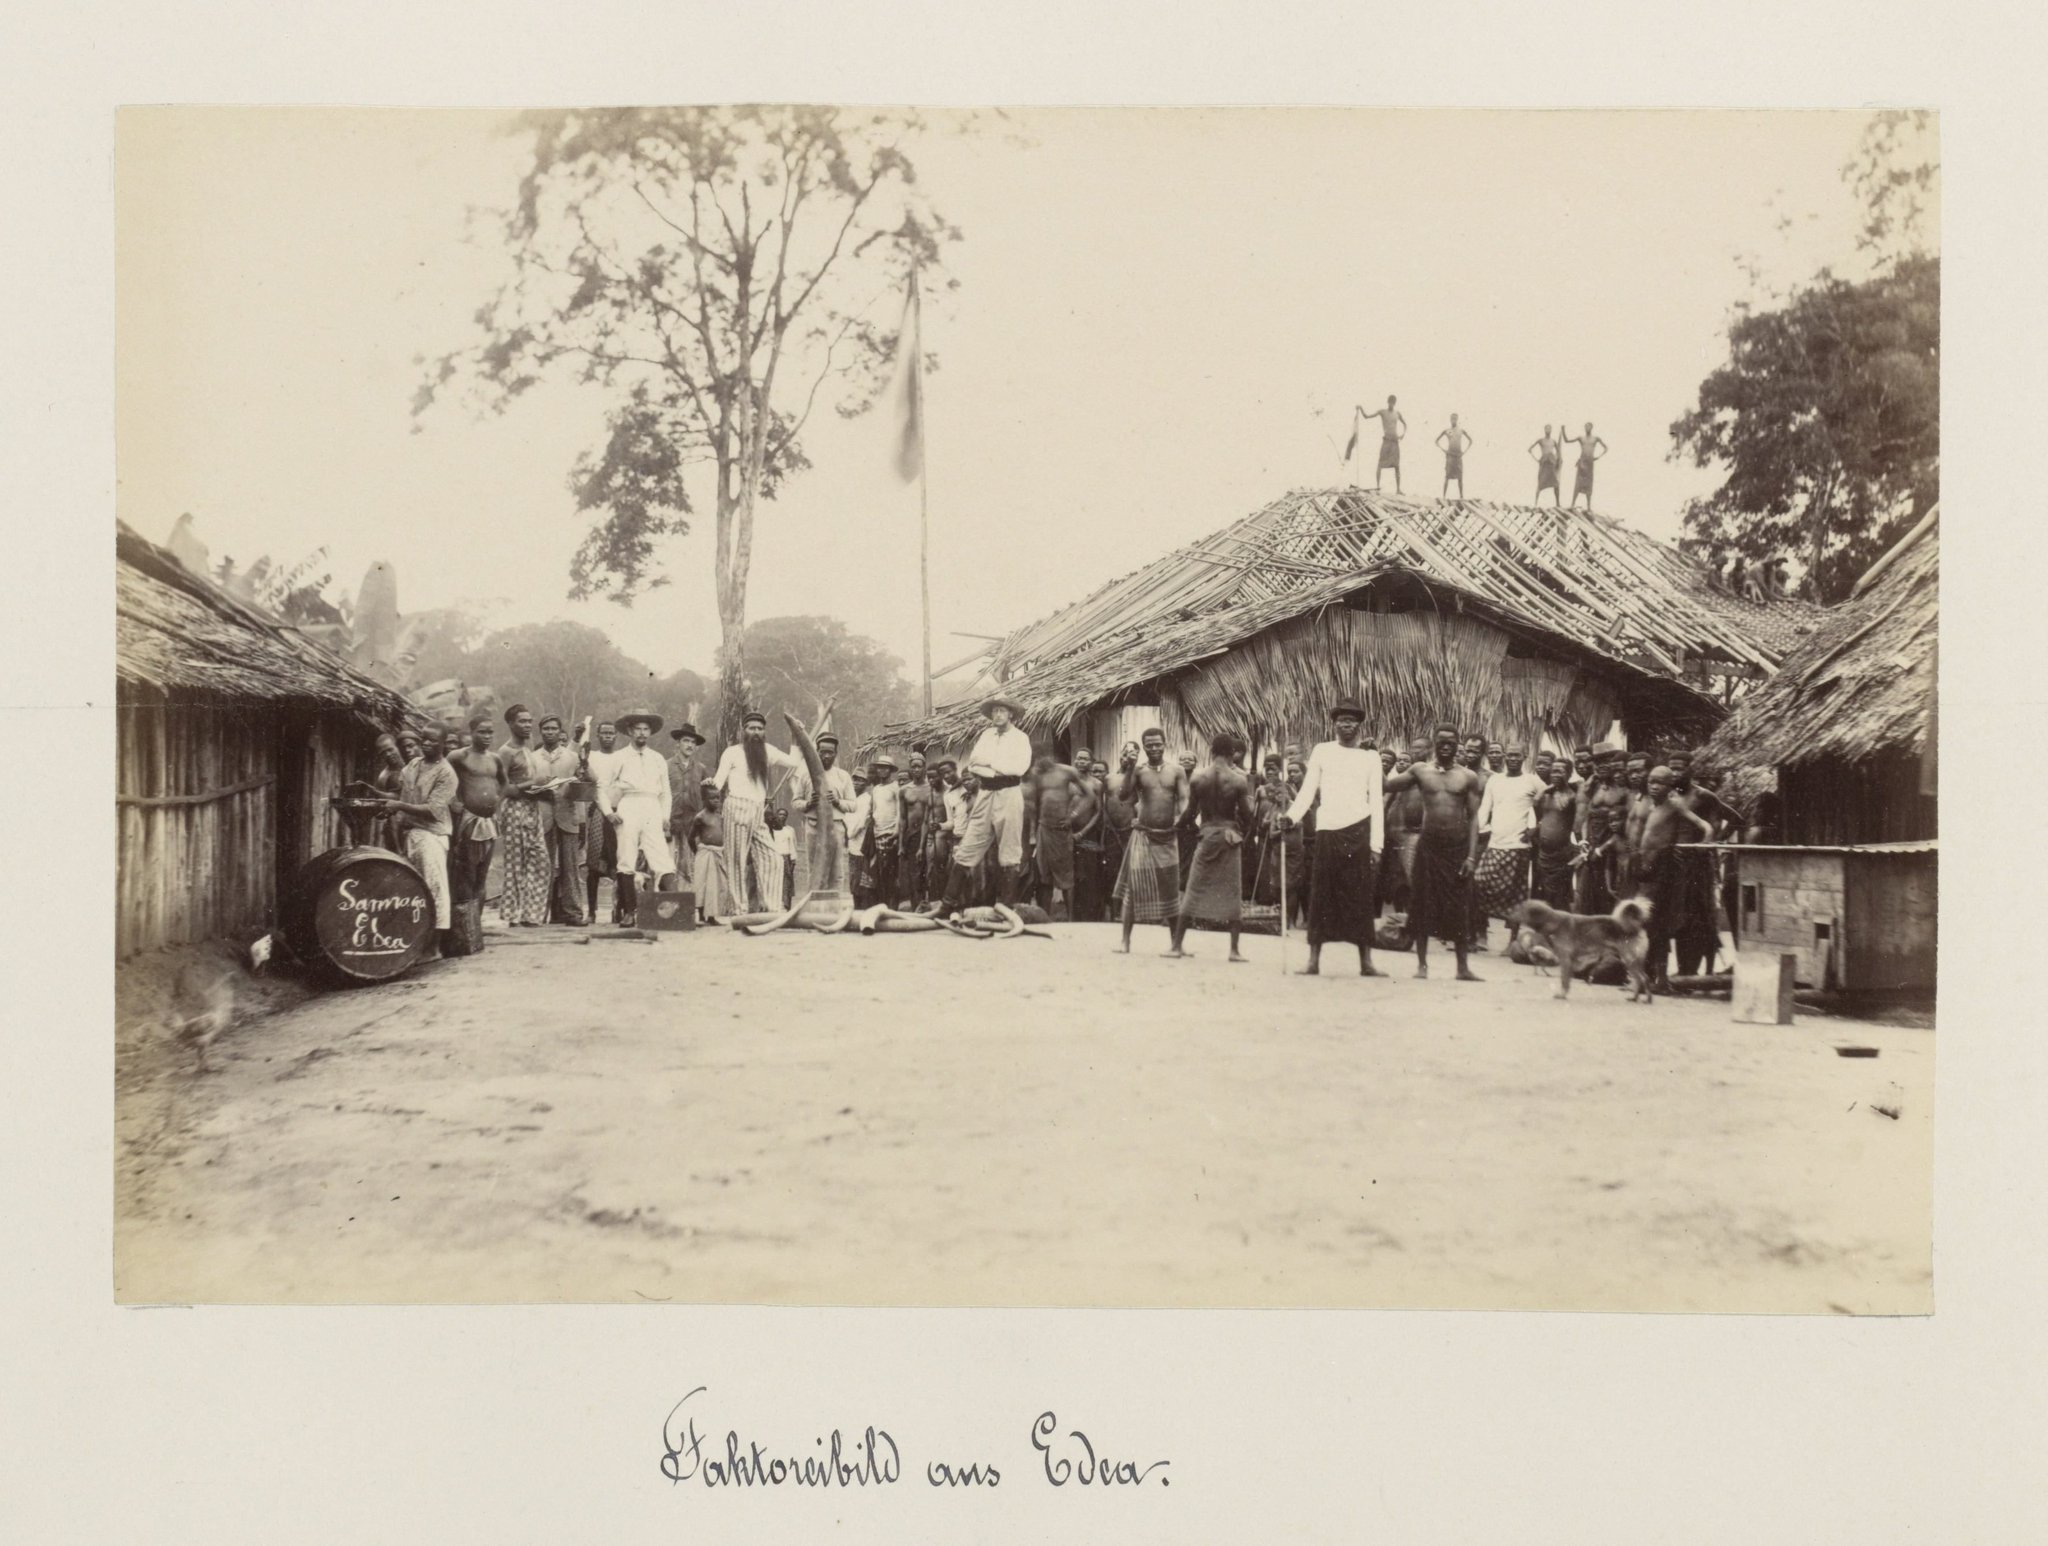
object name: photograph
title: Kameroen, nederzetting Edea met negers bij de hutten rond Duitsers met slagtanden als buit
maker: Anonymous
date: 1899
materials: photographic support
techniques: albumen print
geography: edéa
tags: trade-company, trunked animals: elephant (+ fang, tusk)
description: Onderdeel van Fotoalbum met opnames van Kameroen rond 1899.